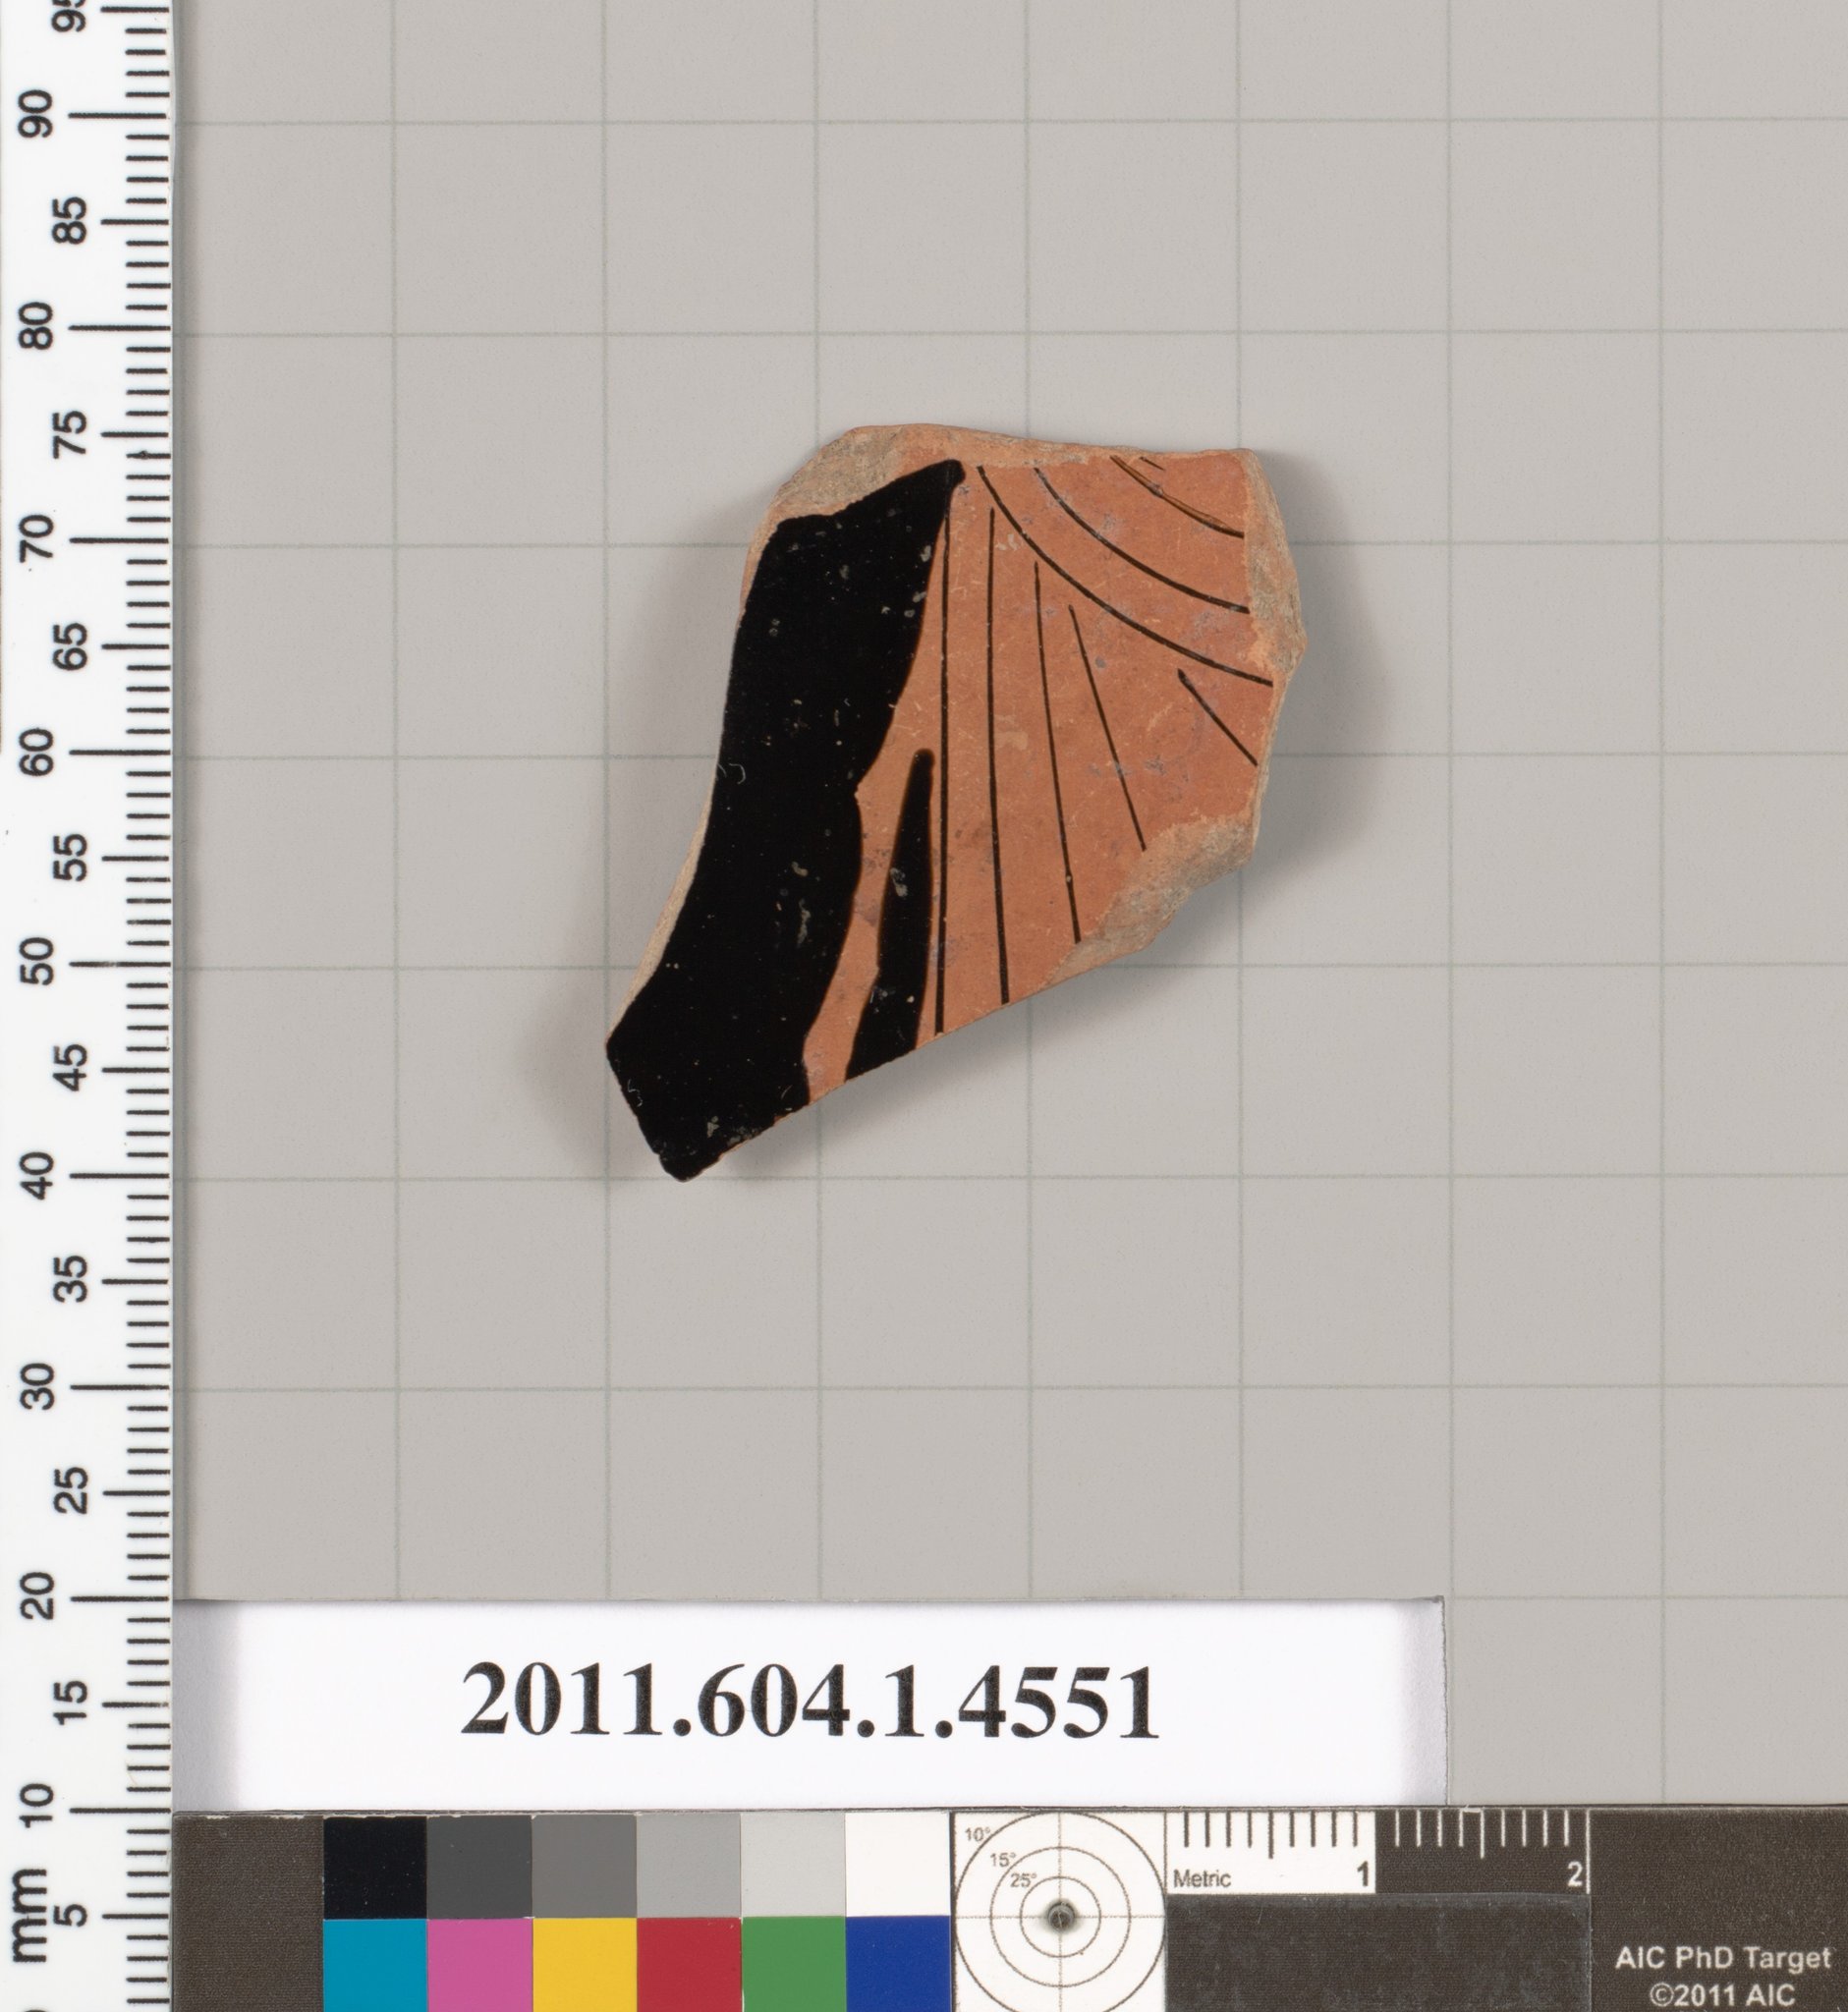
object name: kylix fragment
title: Terracotta fragment of a kylix (drinking cup)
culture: greek, attic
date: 475-451 BCE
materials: terracotta